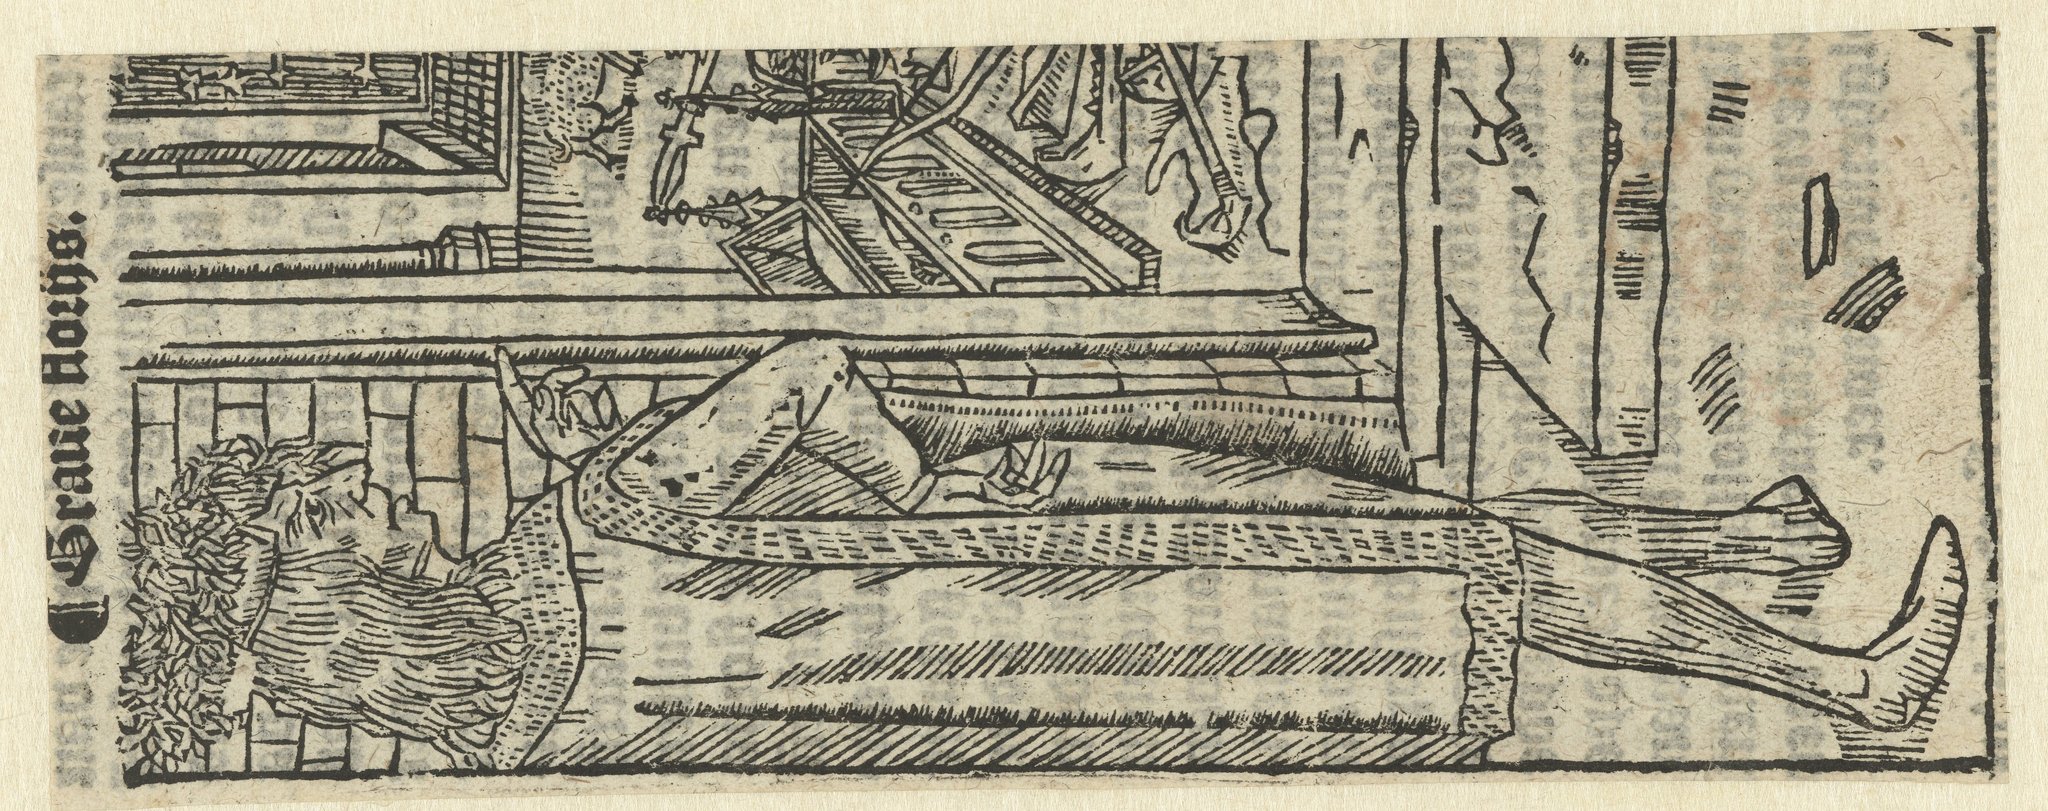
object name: book illustration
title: Graaf Floris (V?)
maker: Anonymous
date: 1517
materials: paper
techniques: woodcut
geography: low countries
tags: leiden, floris v (graaf van holland en zeeland)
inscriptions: collector's mark: Lugt 240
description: Late afdruk van de versneden houtblokken van Le Chevalier déliberé (Gouda 1486). Eén blad van veertien uit Cronycke van Hollandt, uitgegeven door Jan Seversz, te Leiden in 1517 en 1530. Uit blad 2.